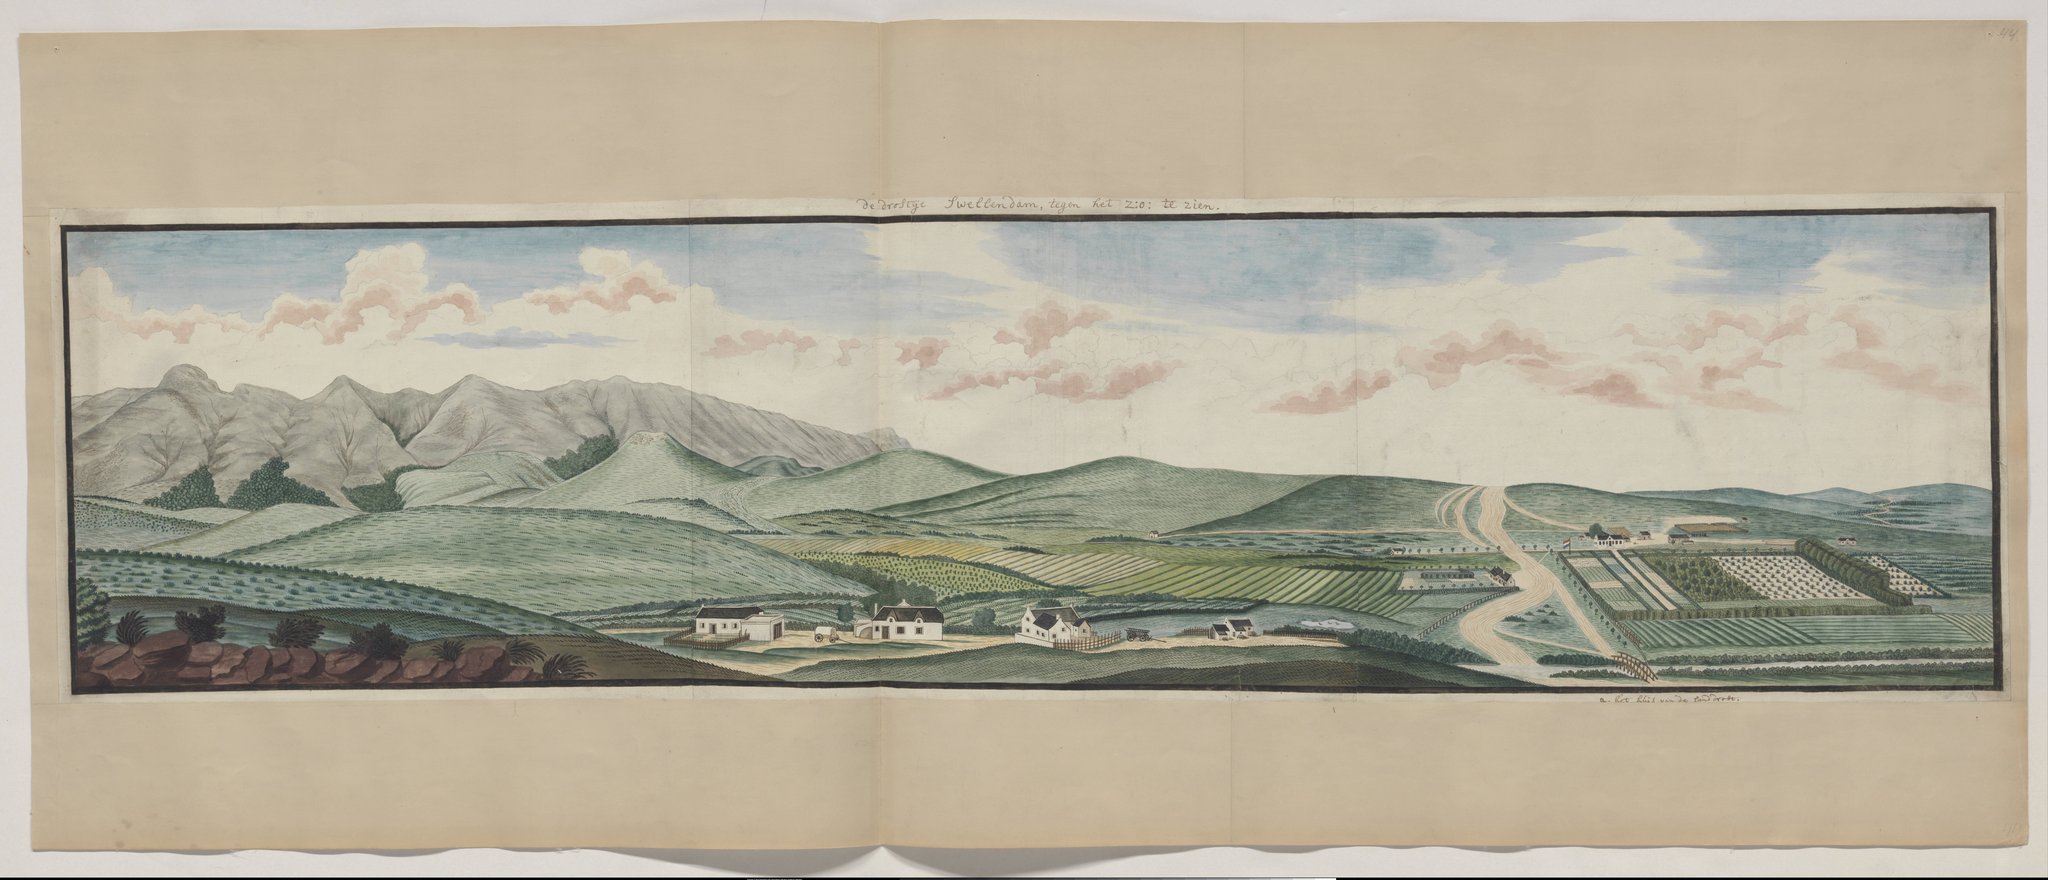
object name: drawing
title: View of the Drostdy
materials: ink, paper, pencil, watercolor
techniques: brush, pen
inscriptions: annotation: ‘bij een huis rechts "a"’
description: Oorspronkelijk in omslag van roodkleurig halfleer en roodgemarmerd plat, dorso met ribben en goudopdruk; 71 x 99 x 6 cm.